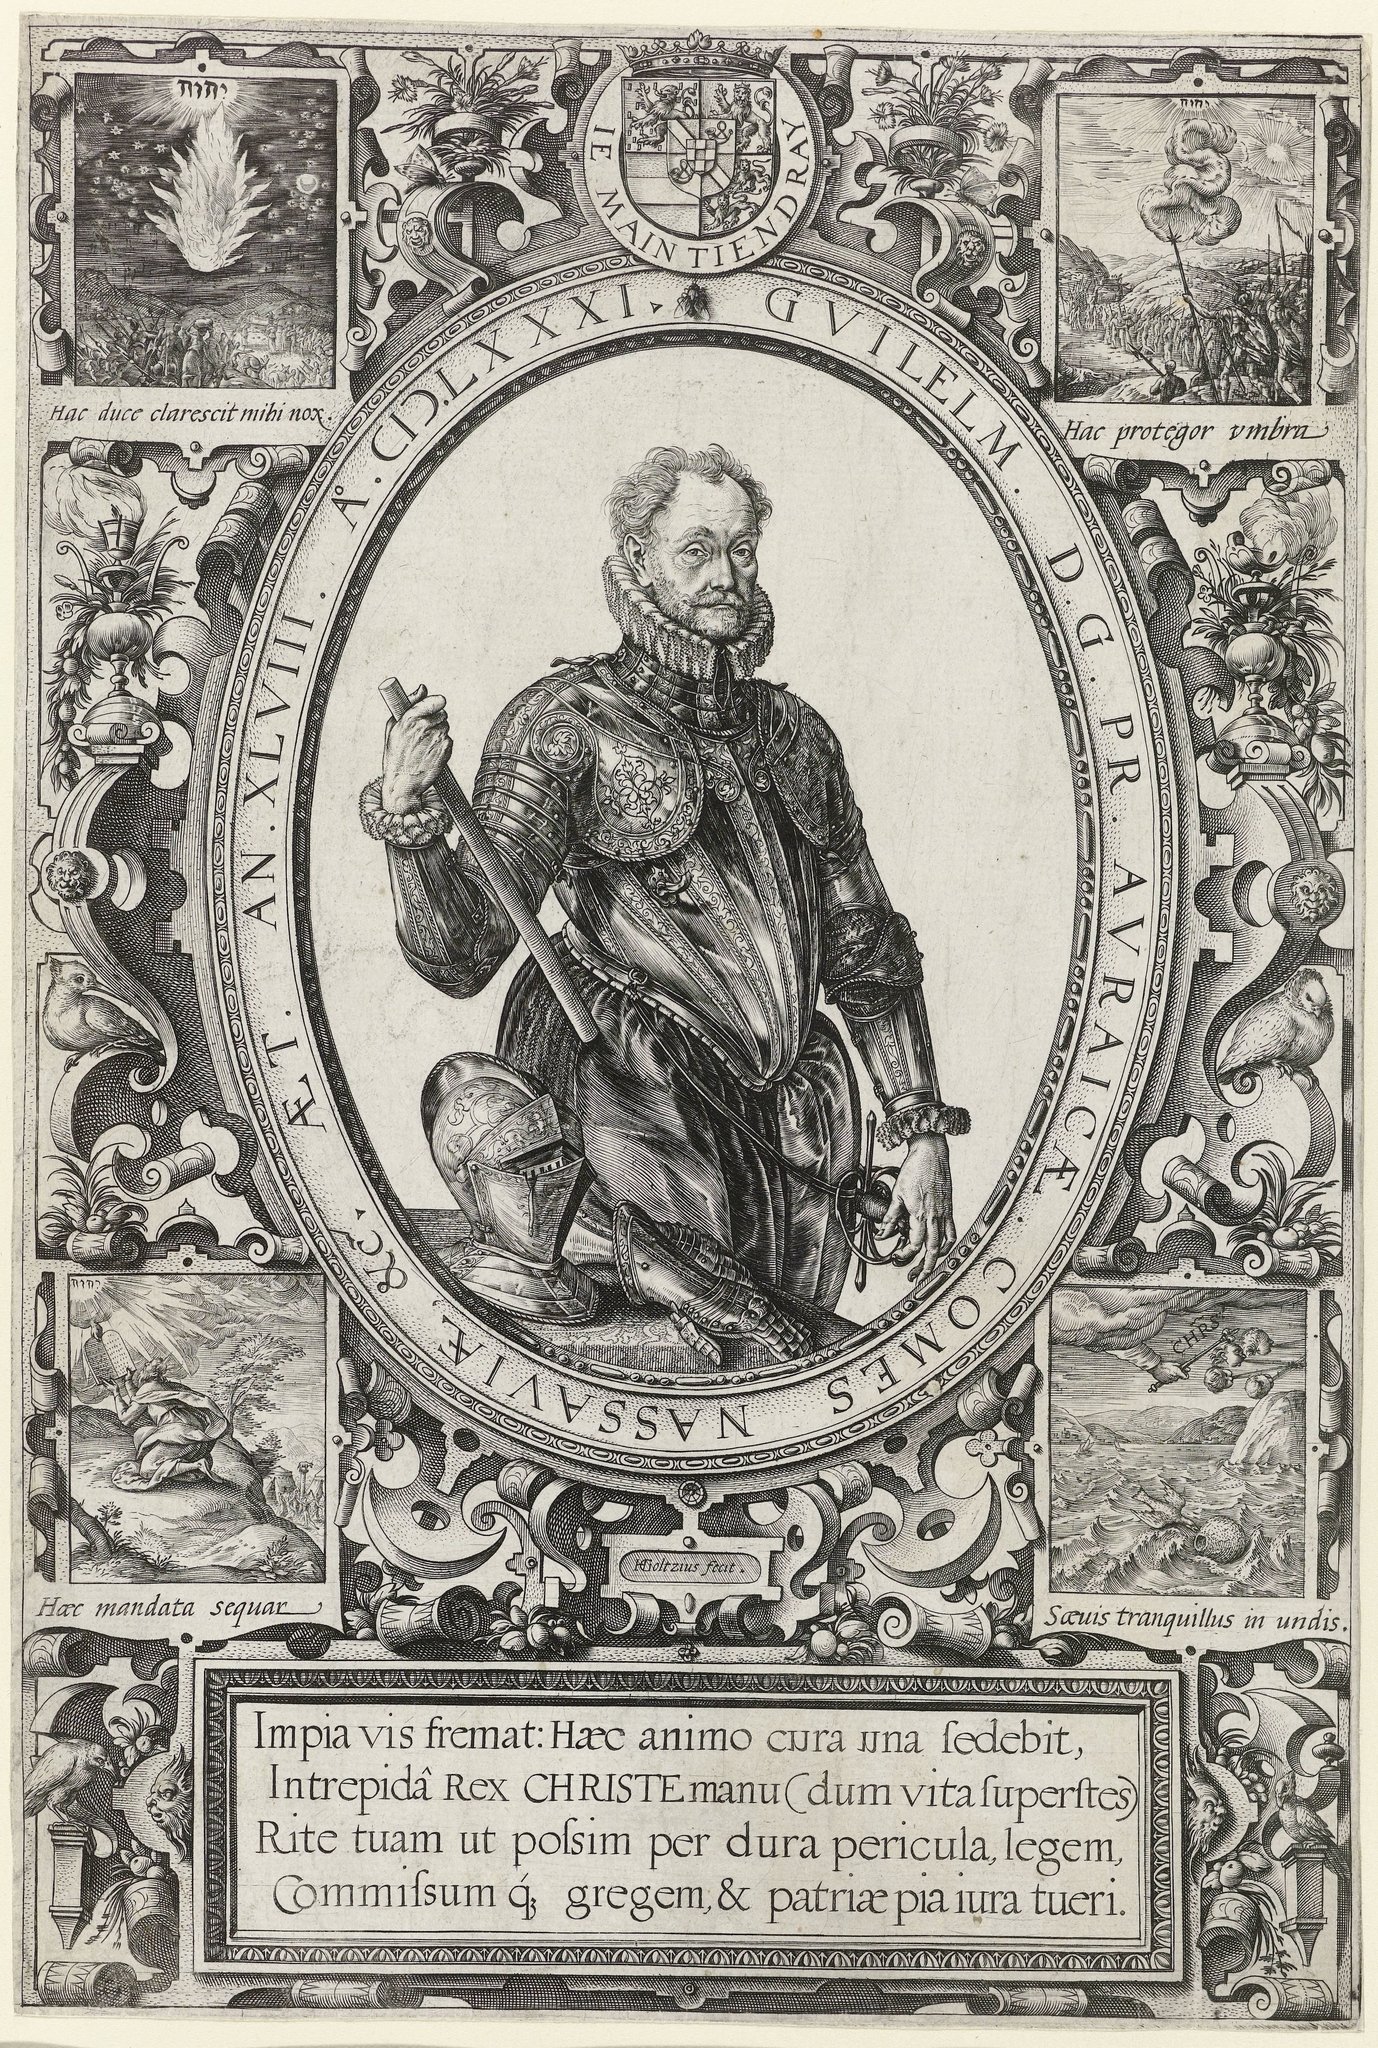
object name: print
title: Portret van Willem van Oranje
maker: hendrick goltzius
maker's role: draughtsman, painter, print maker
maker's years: 1558-1617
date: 1581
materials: paper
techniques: engraving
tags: delft, william i (prince of orange), the pillar of cloud and the pillar of fire ~ exodus, commander-in-chief, general, marshal, armour, historical persons, moses receives the tables of the law from god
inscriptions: caption: ‘Impia vis fremat:...pia iura tueri.’, inscription: ‘JE MAINTIENDRAY’, edge inscription: ‘GVILELM. D.G. ...LXXXI.’, signature: ‘HGoltzius fecit.’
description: Prins Willem van Oranje (1533-1584) speelde een centrale rol in de beginjaren van de Nederlandse opstand tegen de Spaanse koning. Hier staat hij, gekleed in militair tenue, afgebeeld als leider van de opstand. Hendrick Goltzius moet vereerd zijn geweest dat hij al op 23-jarige leeftijd de prins van Oranje mocht portretteren. De kleine voorstellingen in de indrukwekkende omlijsting verwijzen naar bijbelverhalen. De gravure van Willem van Oranje heeft als pendant het portret van Charlotte de Bourbon, zijn derde echtgenote. (RP-P-1940-258)